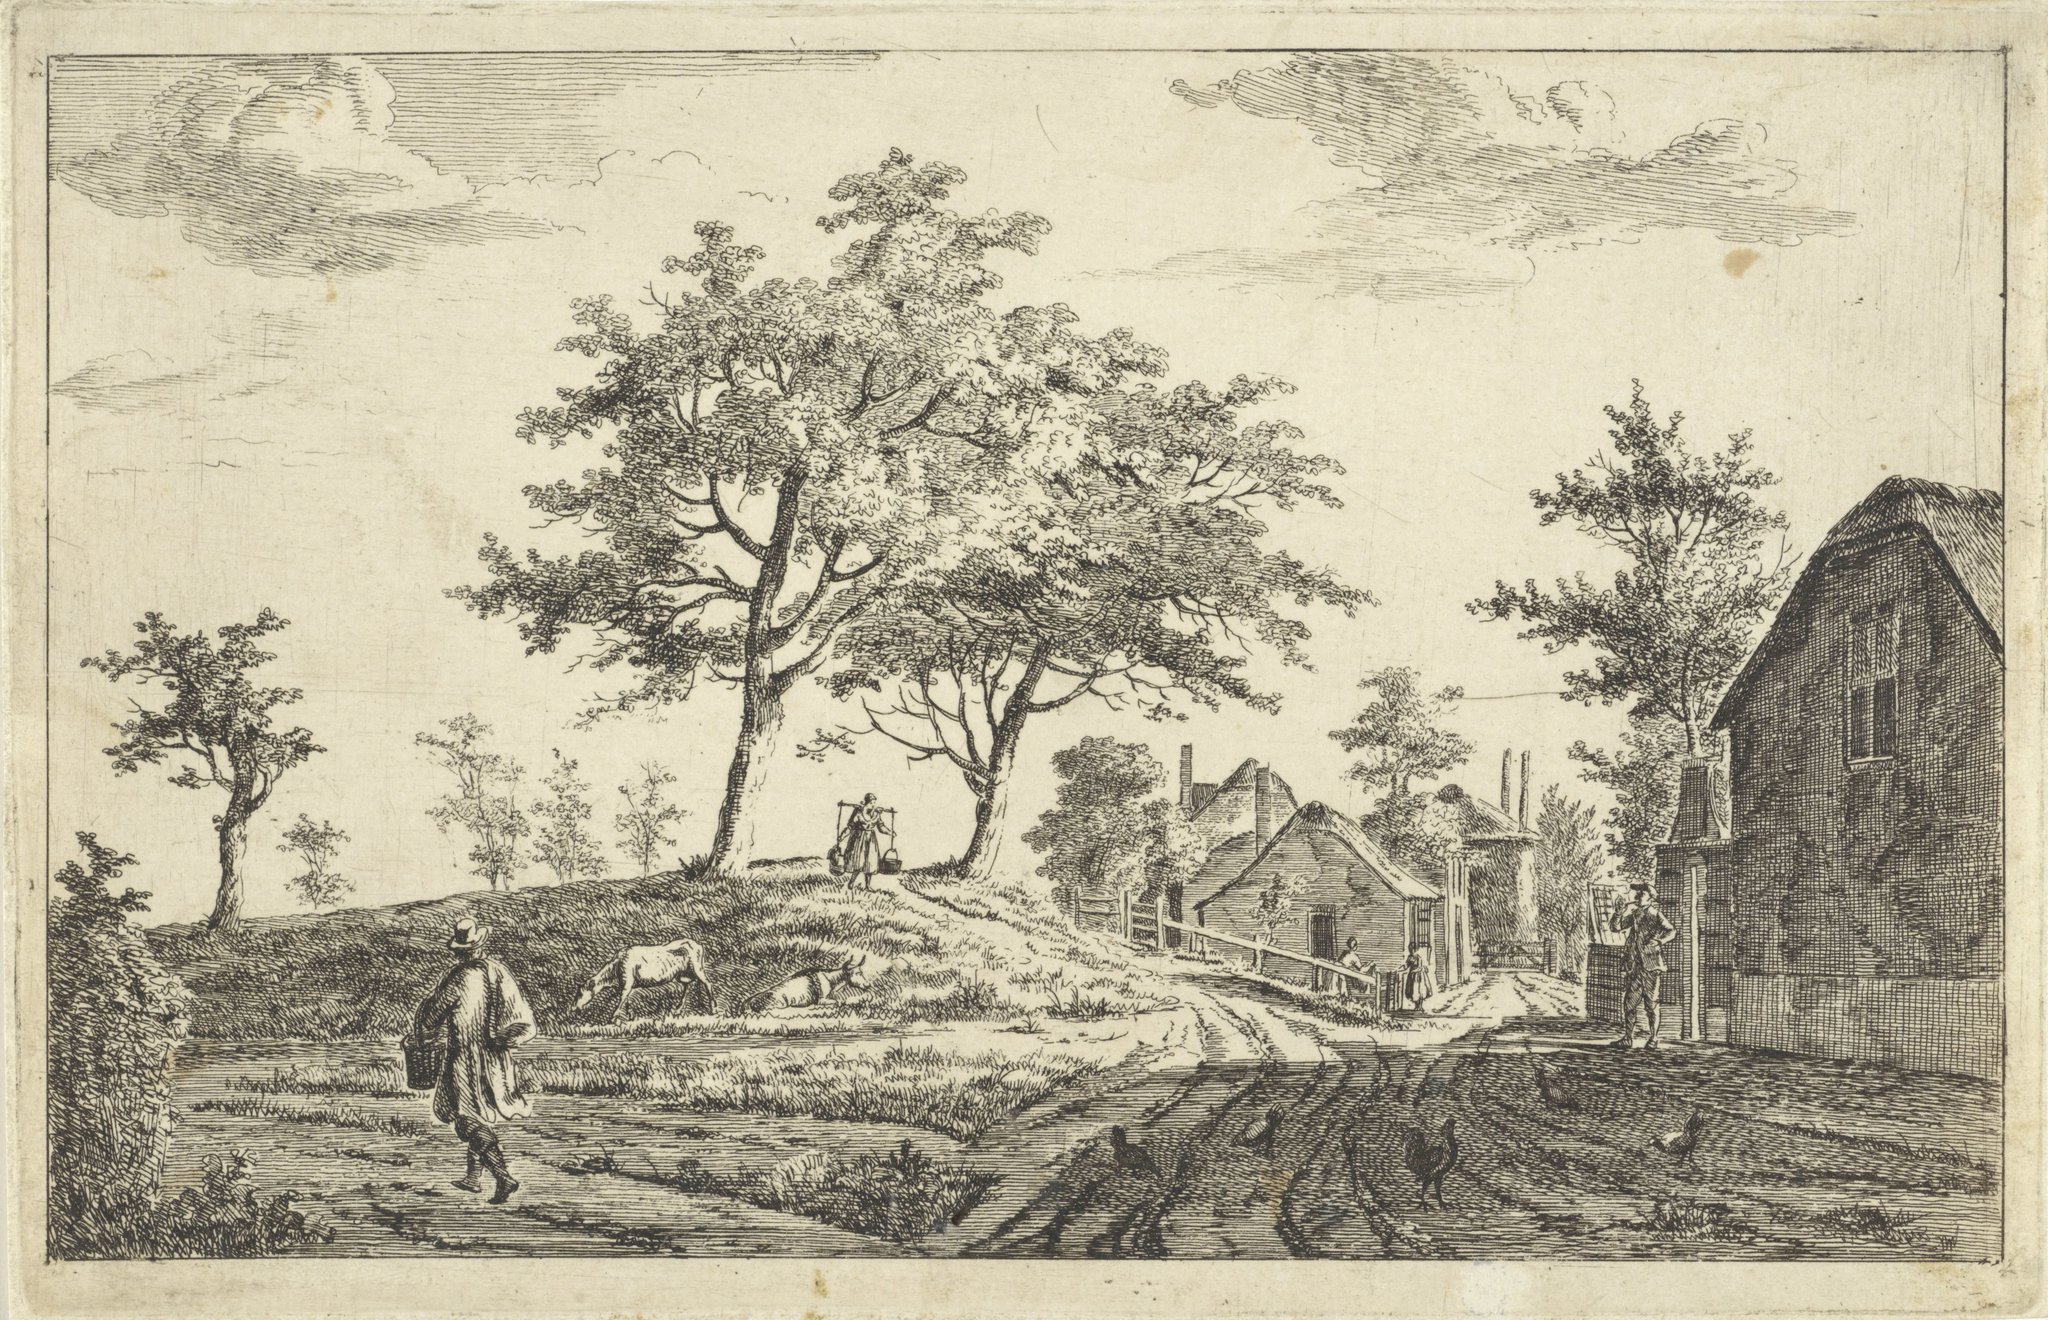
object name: print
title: Gezicht op een weg door een dorp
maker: adrianus serné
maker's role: print maker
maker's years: 1773-1853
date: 1783-1853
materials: paper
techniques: etching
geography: netherlands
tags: public road in village, hay-stack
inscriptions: collector's mark: Lugt 2228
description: Gezicht op een weg door een dorp. Links een heuvel waarop een vrouw met juk en emmers loopt.